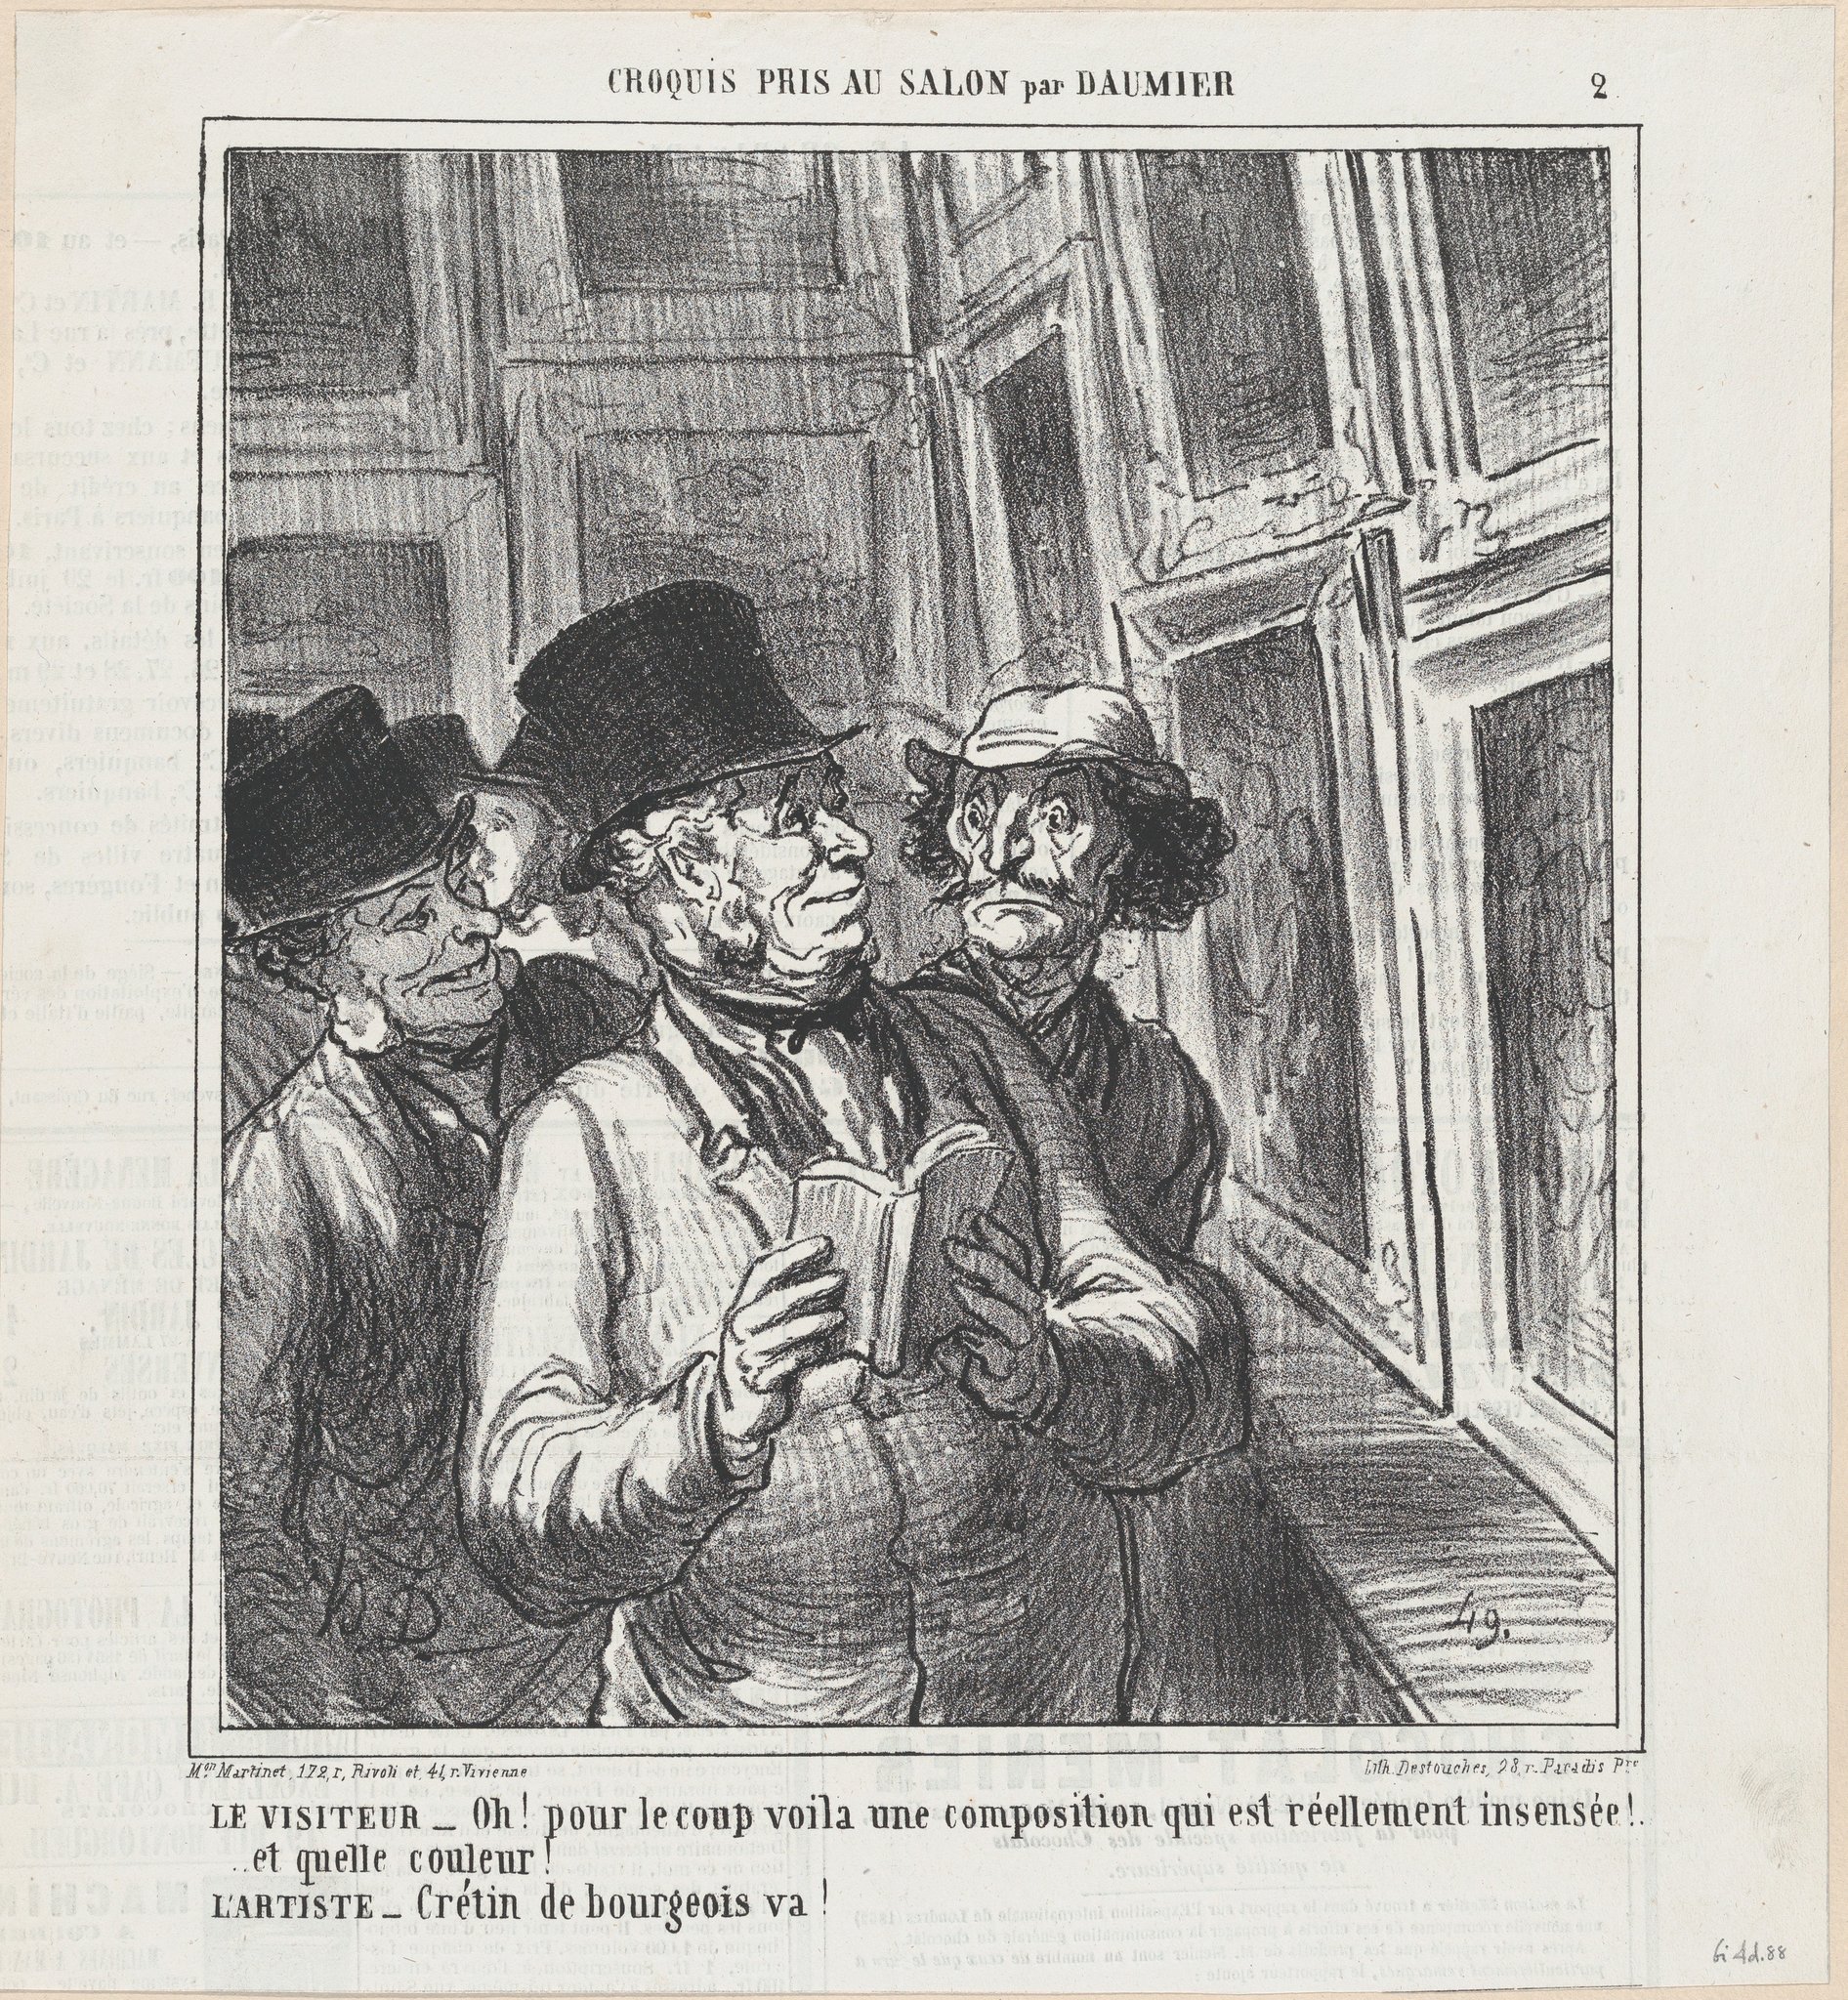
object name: print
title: The visitor and the artist, from 'Sketches from the Salon,' published in Le Charivari, May 30, 1864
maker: honoré daumier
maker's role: artist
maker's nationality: french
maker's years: 1808-1879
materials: paper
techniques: lithograph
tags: satire,men